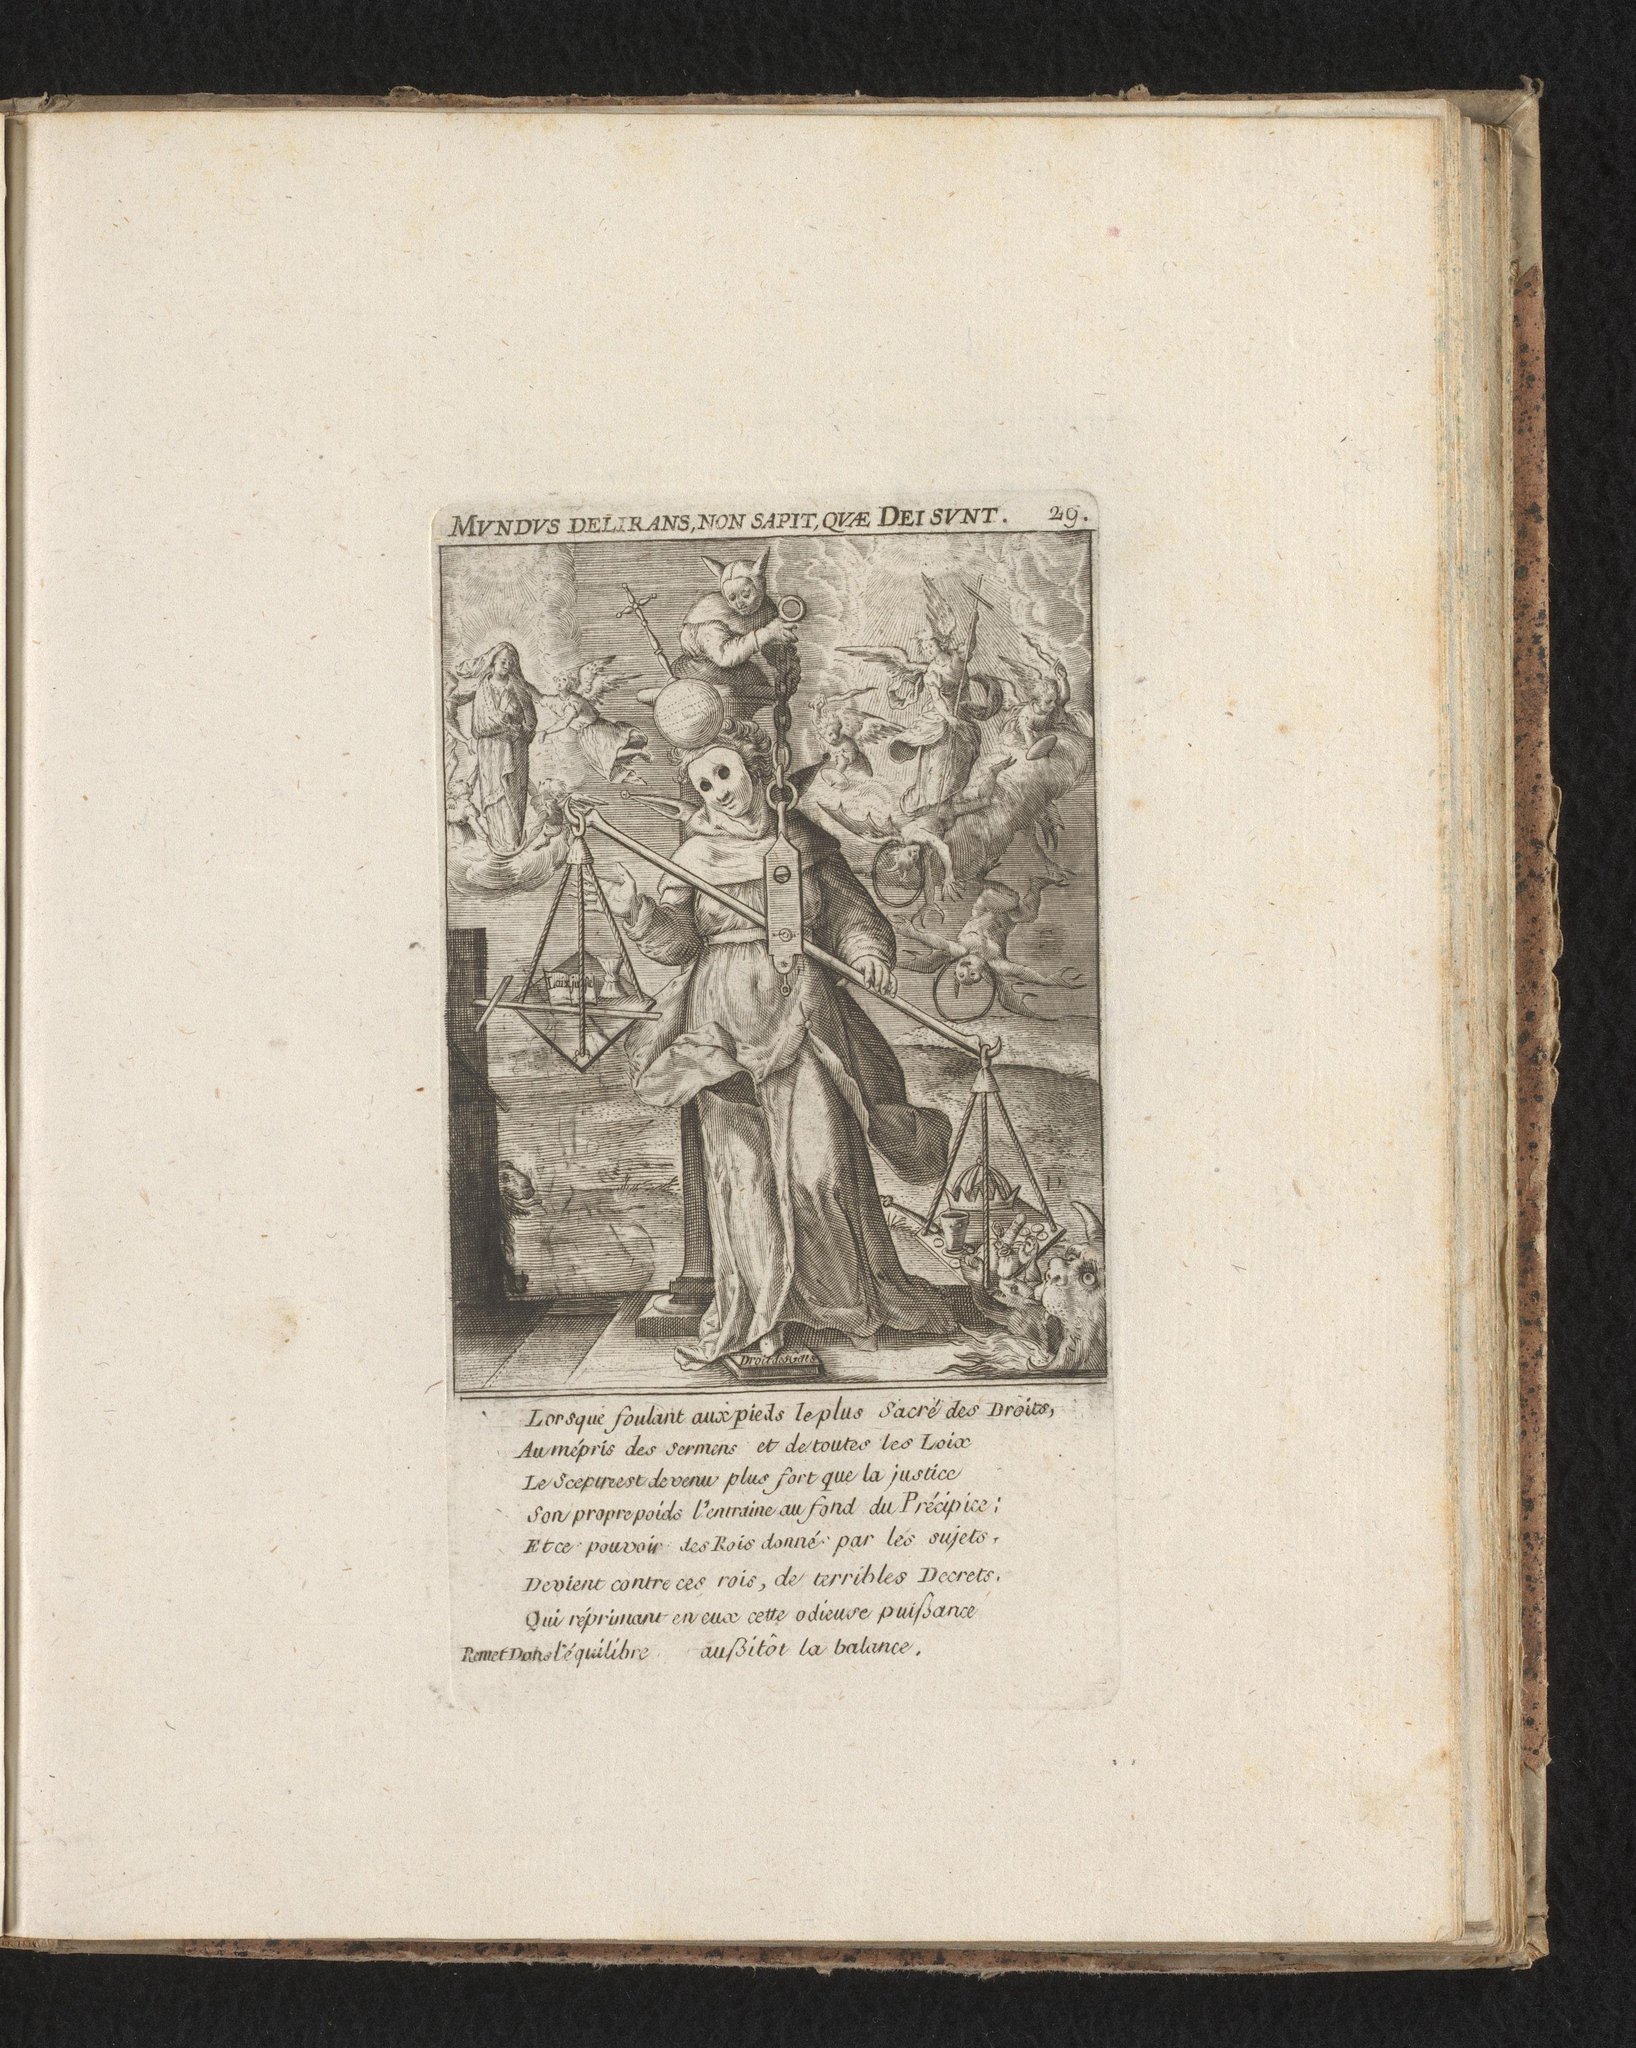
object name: print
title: Dwaasheid van wereldse goederen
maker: Anonymous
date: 1575-1599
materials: paper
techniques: engraving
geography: southern netherlands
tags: court jester, court fool, scales, psychostasis, the archangel michael weighing the souls in the scales (and stabbing the devil), 'frau welt', brabant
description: Allegorie met gemaskerde Vrouw Wereld in narrenpak. Op haar hoofd zit een nar met weegschalen waarin de wereldse goederen zwaarder wegen dan een kruisbeeld en een wetboek. Links wordt een ziel naar de hemel gevoerd, rechts storten duivels in de hel. Genummerd rechtsboven: 29. Met vers van acht regels in het Frans onder de voorstelling. Onderdeel van de gebundelde verzameling prenten betrekking hebbend op de gebeurtenissen van de Brabantse Omwenteling en de periode 1787-1790.